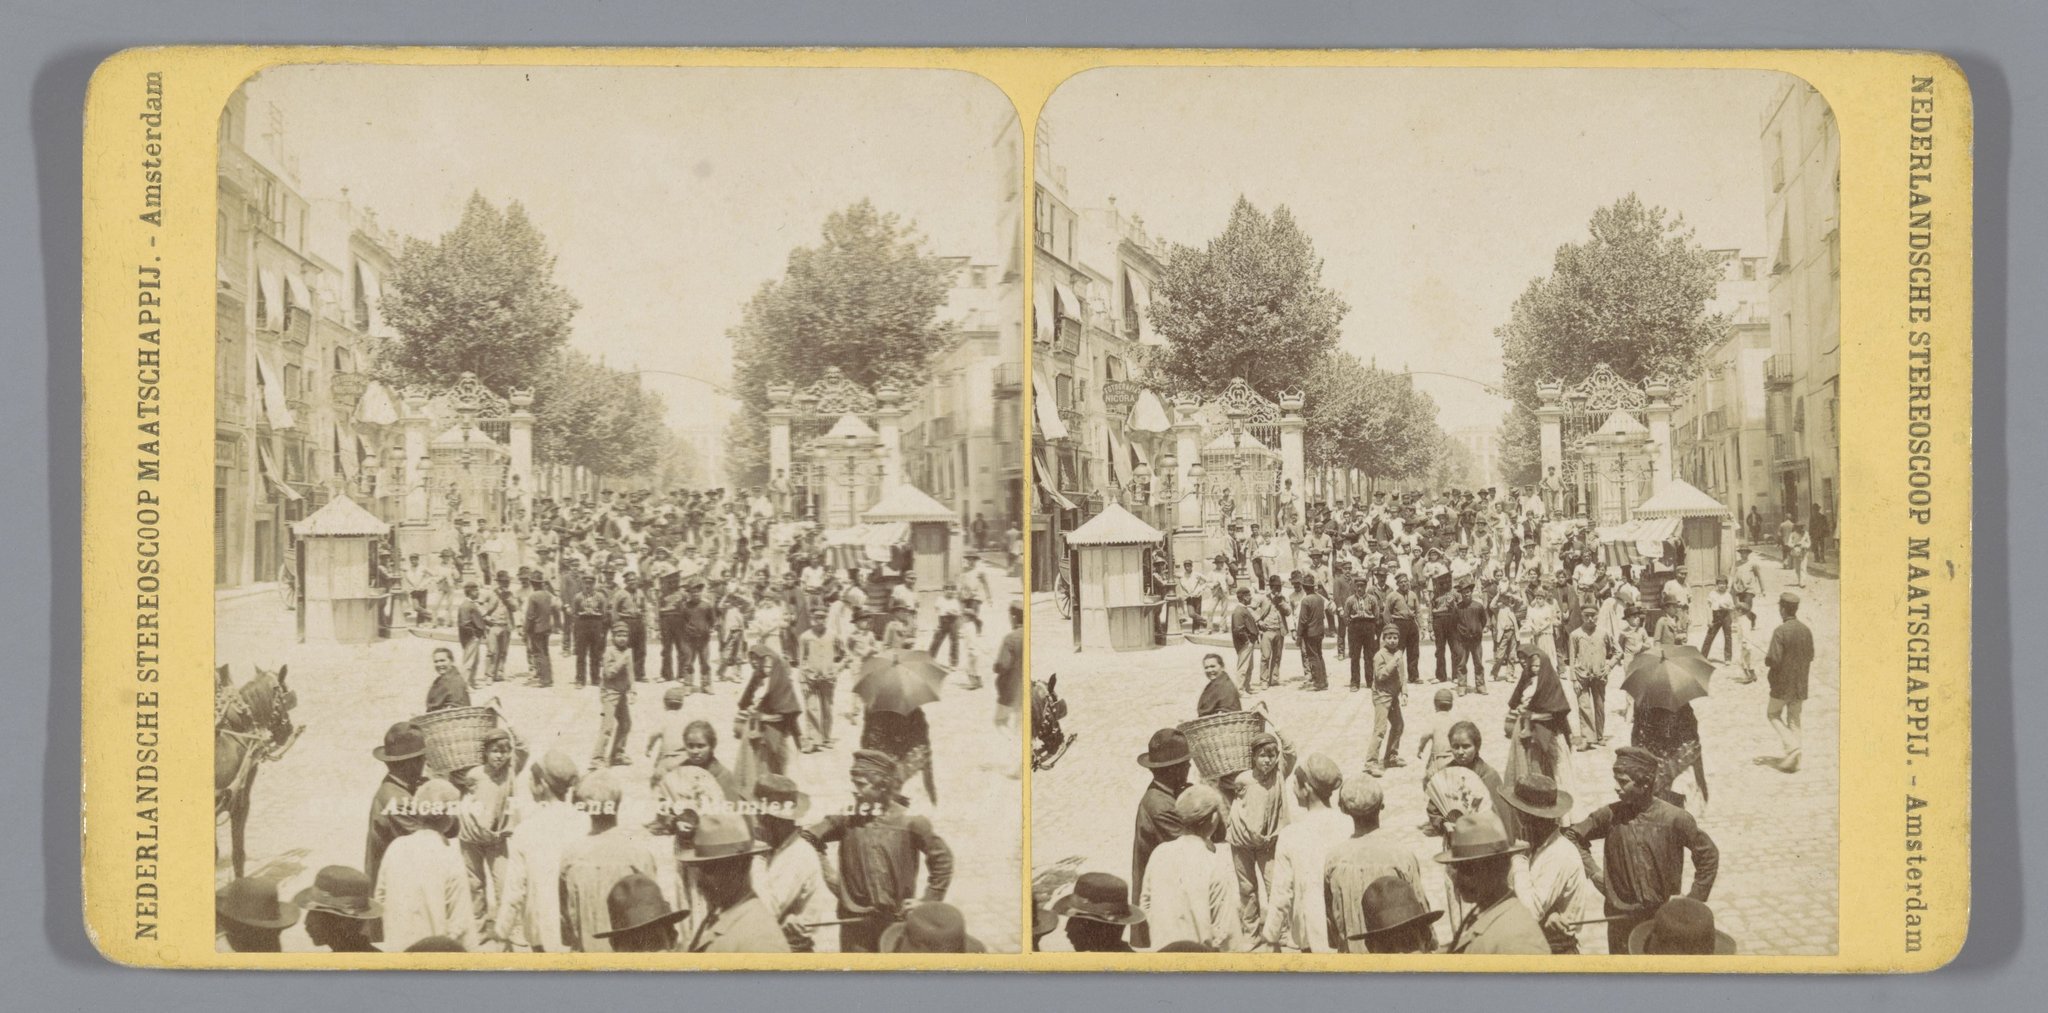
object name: stereograph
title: Alicante. Promenade de Mamies (...)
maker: j.g. beers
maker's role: fotograaf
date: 1850-1880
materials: cardboard, photographic support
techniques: albumen print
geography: amsterdam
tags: avenue, boulevard, promenade, esplanade